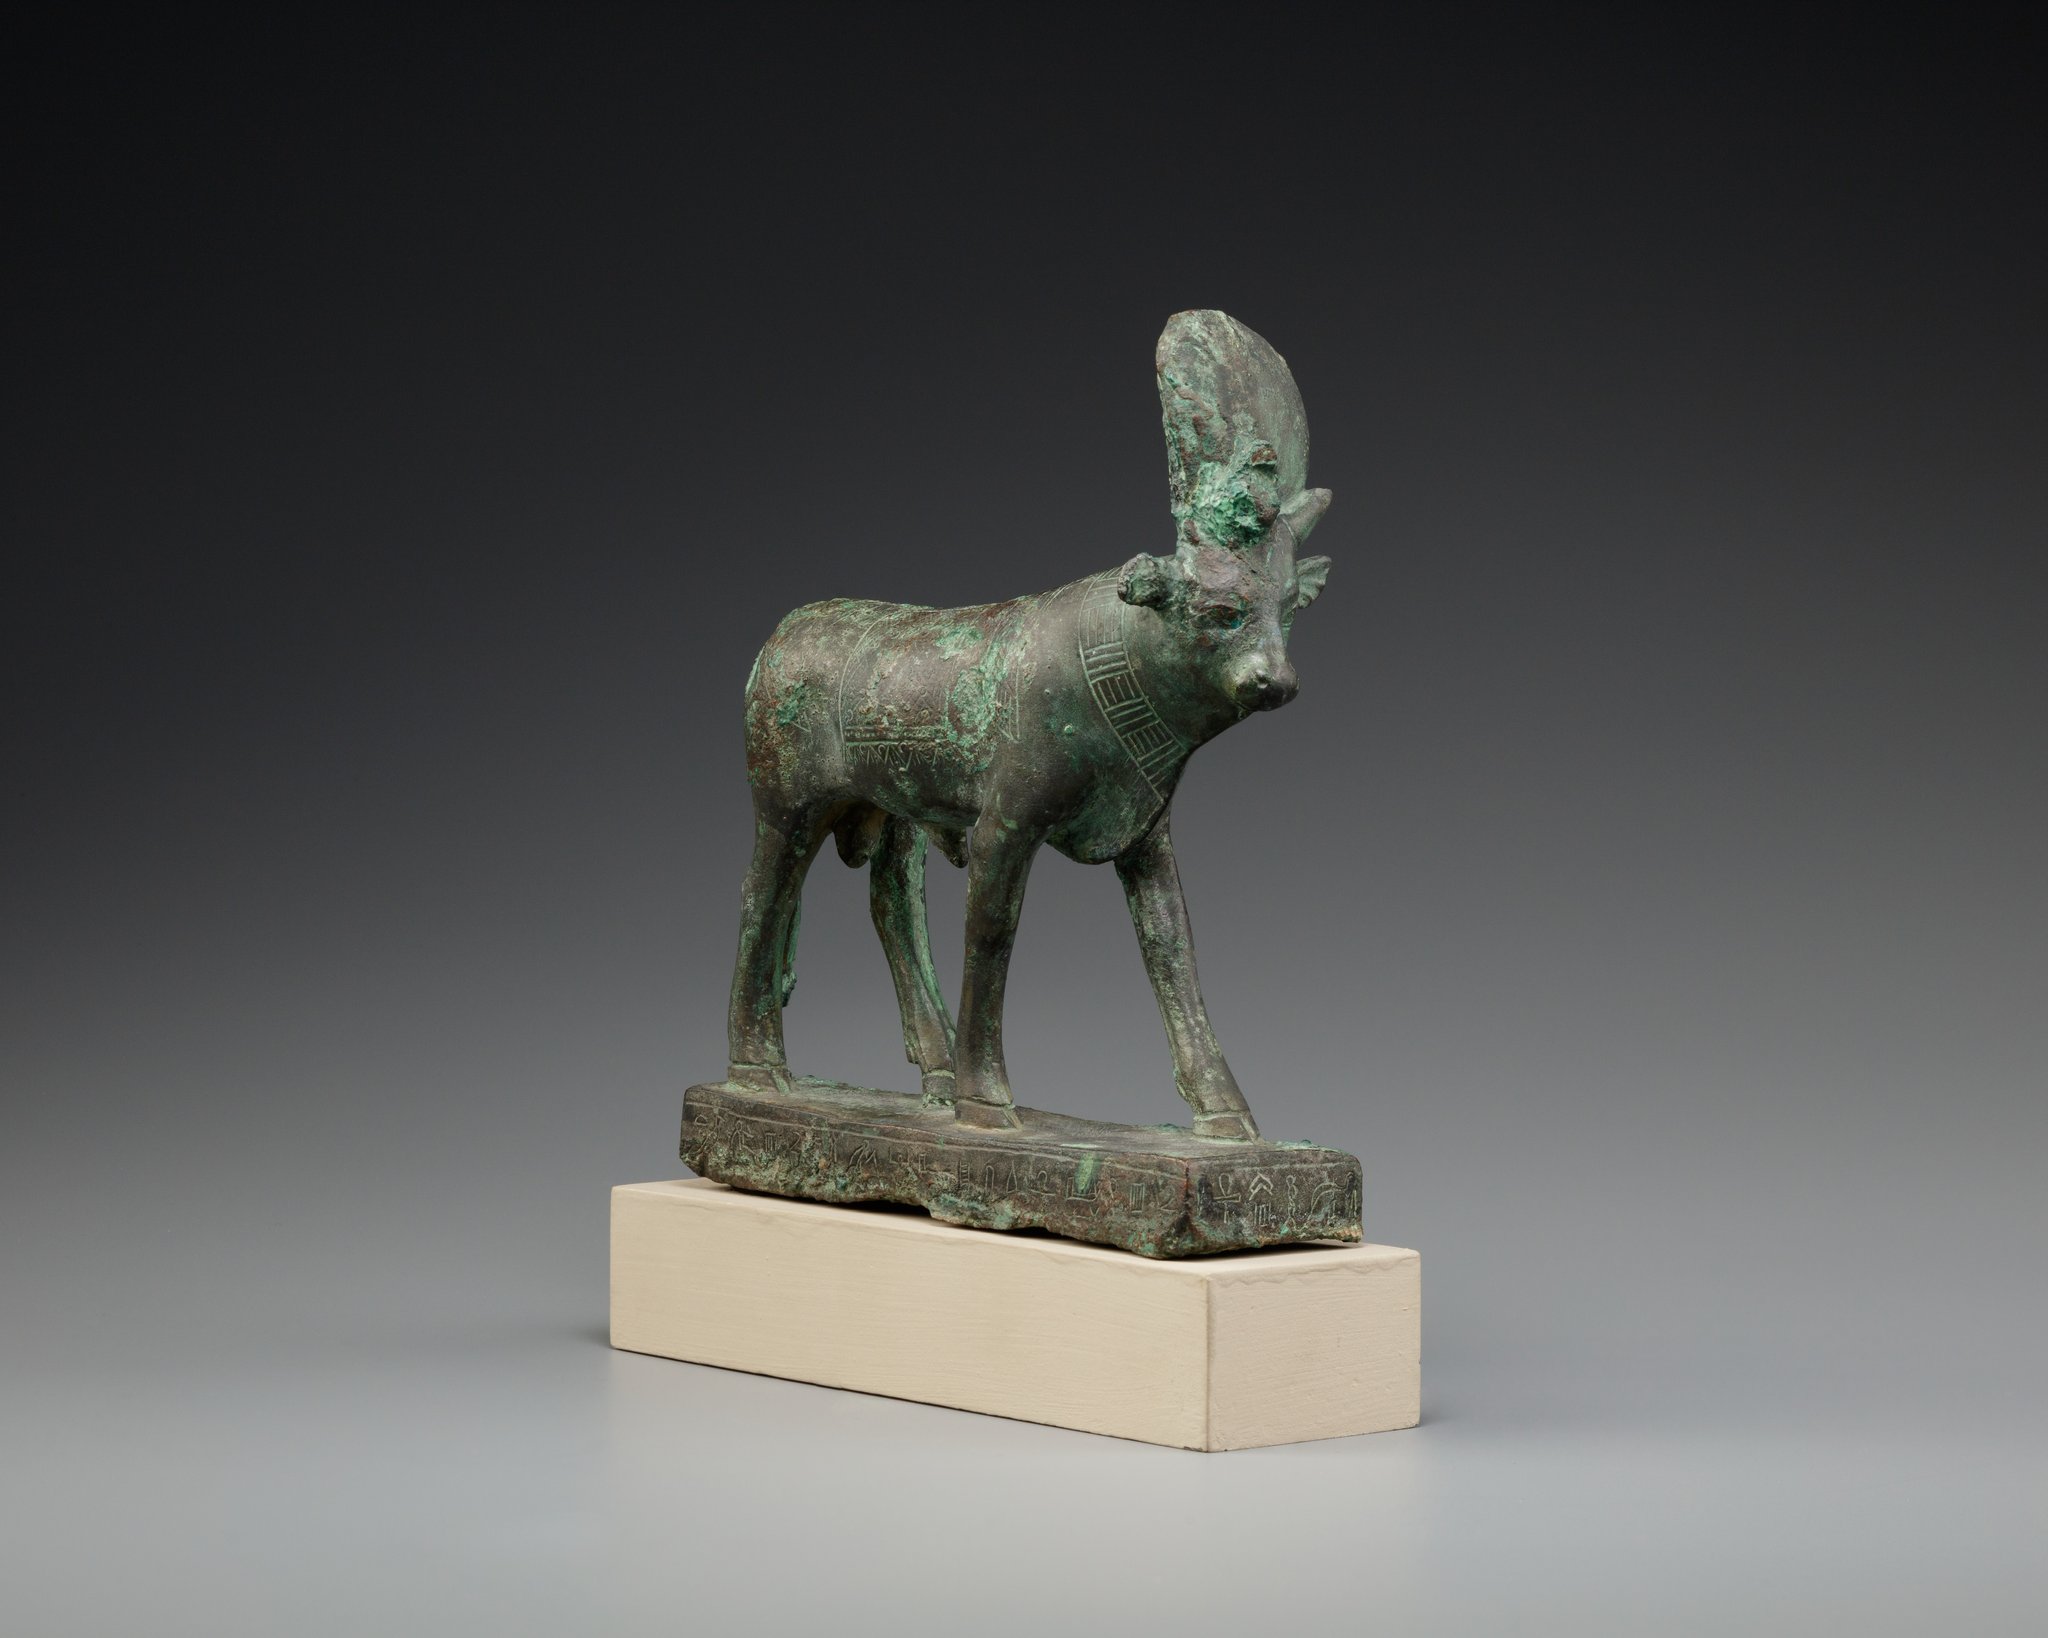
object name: figurine, apis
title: Apis with an inscription invoking Ptah for the benefit of Pasheryta[...] whose mother was Isetemhat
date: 664-332 BCE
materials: metal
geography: egypt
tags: bulls